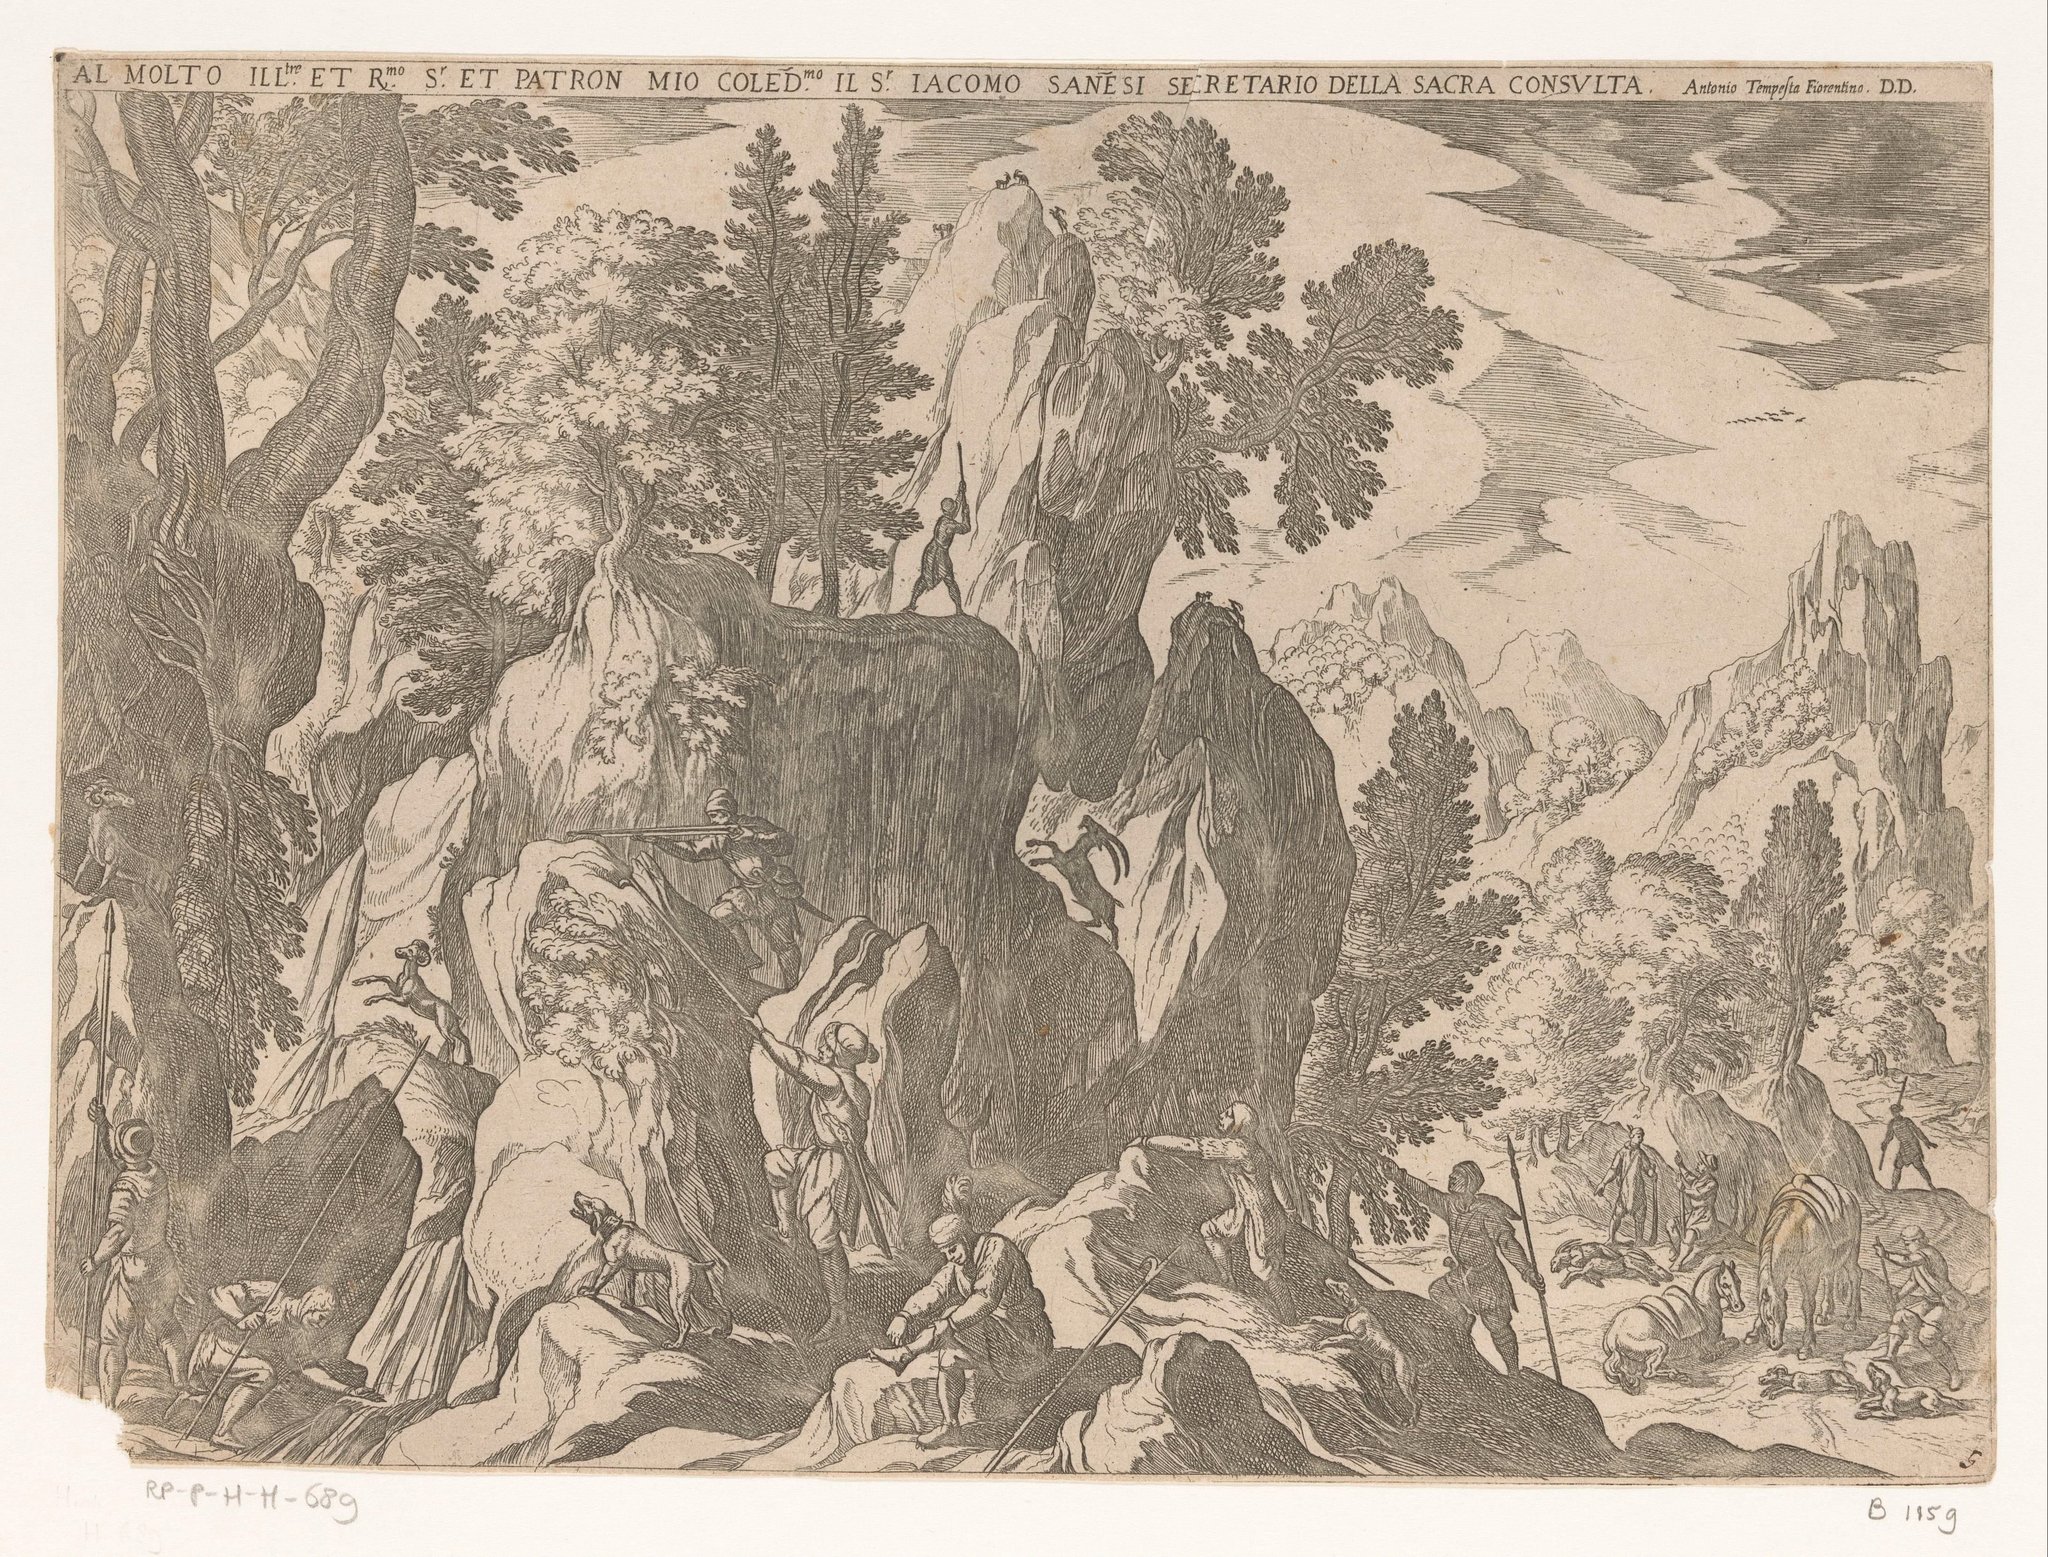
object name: print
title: Jacht op berggeiten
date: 1599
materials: paper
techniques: etching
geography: rome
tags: hunter, hunters hunting (n.b.: in 1988-1990 this notation denoted the concept of 43c11421 'hunters resting during the hunt'), goat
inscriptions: collector's mark: Lugt 11, number: ‘5’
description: Deze prent maakt deel uit van een reeks van vier prenten met jachtscènes. Hoek linksonder met signatuur Tempesta is afgescheurd.